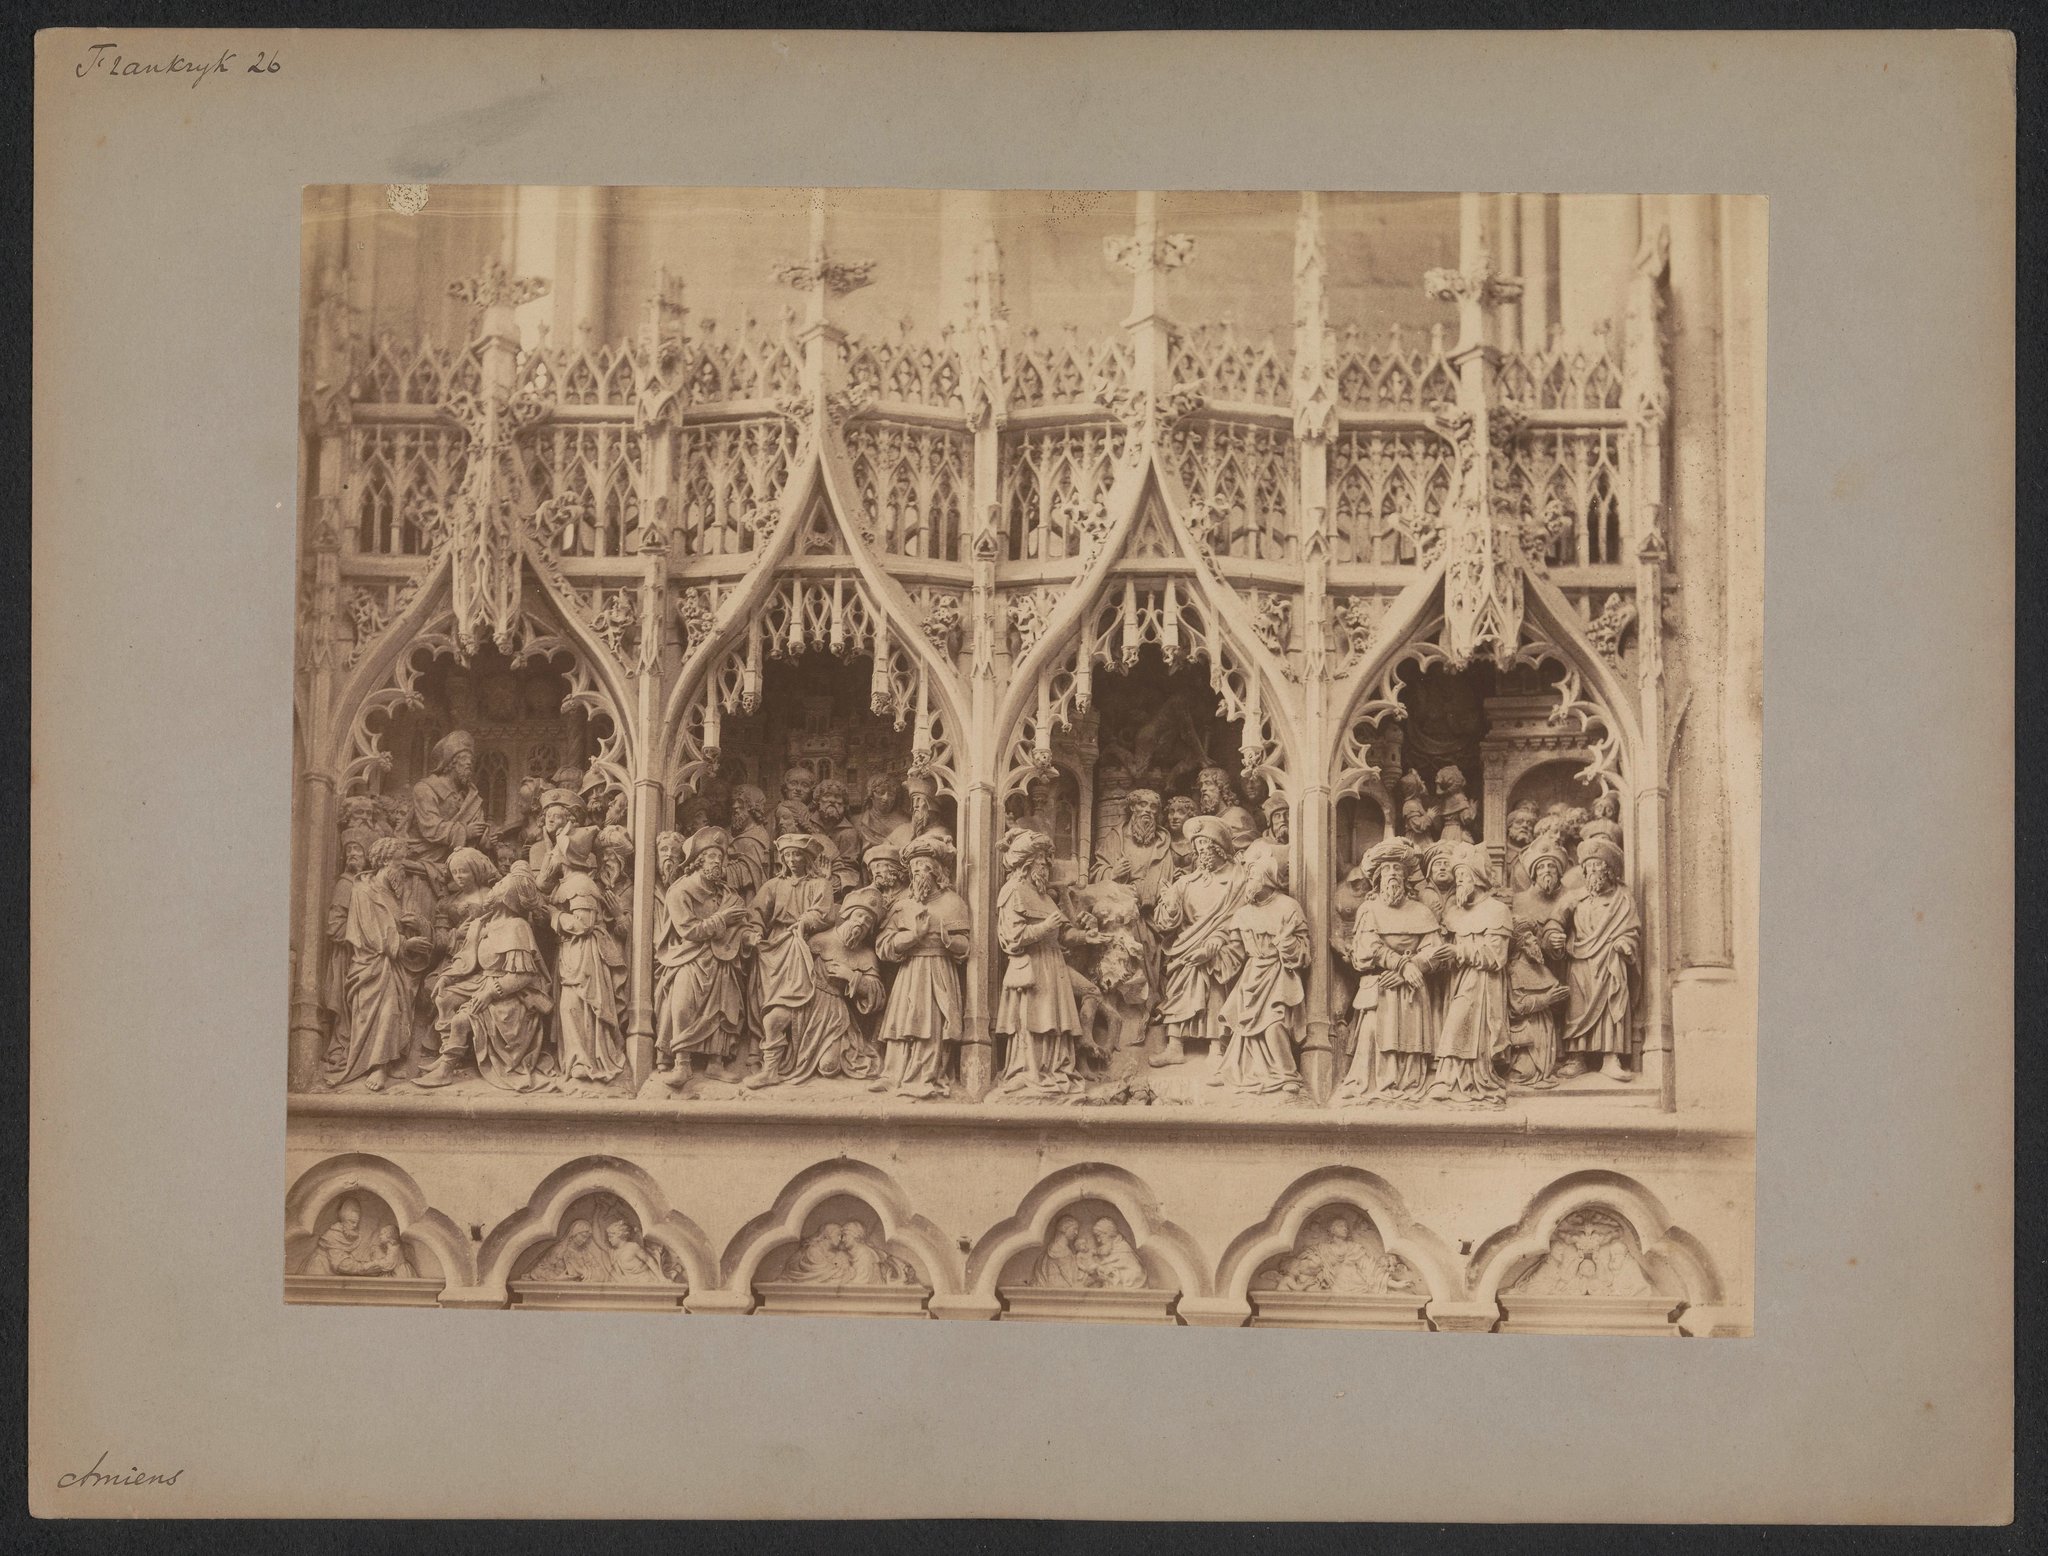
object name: photograph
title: Detail van de Notre-Dame in Amiens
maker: Anonymous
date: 1850-1900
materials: cardboard, photographic support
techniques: albumen print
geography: notre-dame d'amiens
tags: interior of church, notre-dame d'amiens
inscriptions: collector's mark: ‘RIJKS NORMAALSCHOOL voor T[EEKENONDERWIJZERS] AMSTERDAM’, annotation: ‘Frankrijk 26’, annotation: ‘Cathedraal te/ Amiens’, annotation: ‘Amiens’